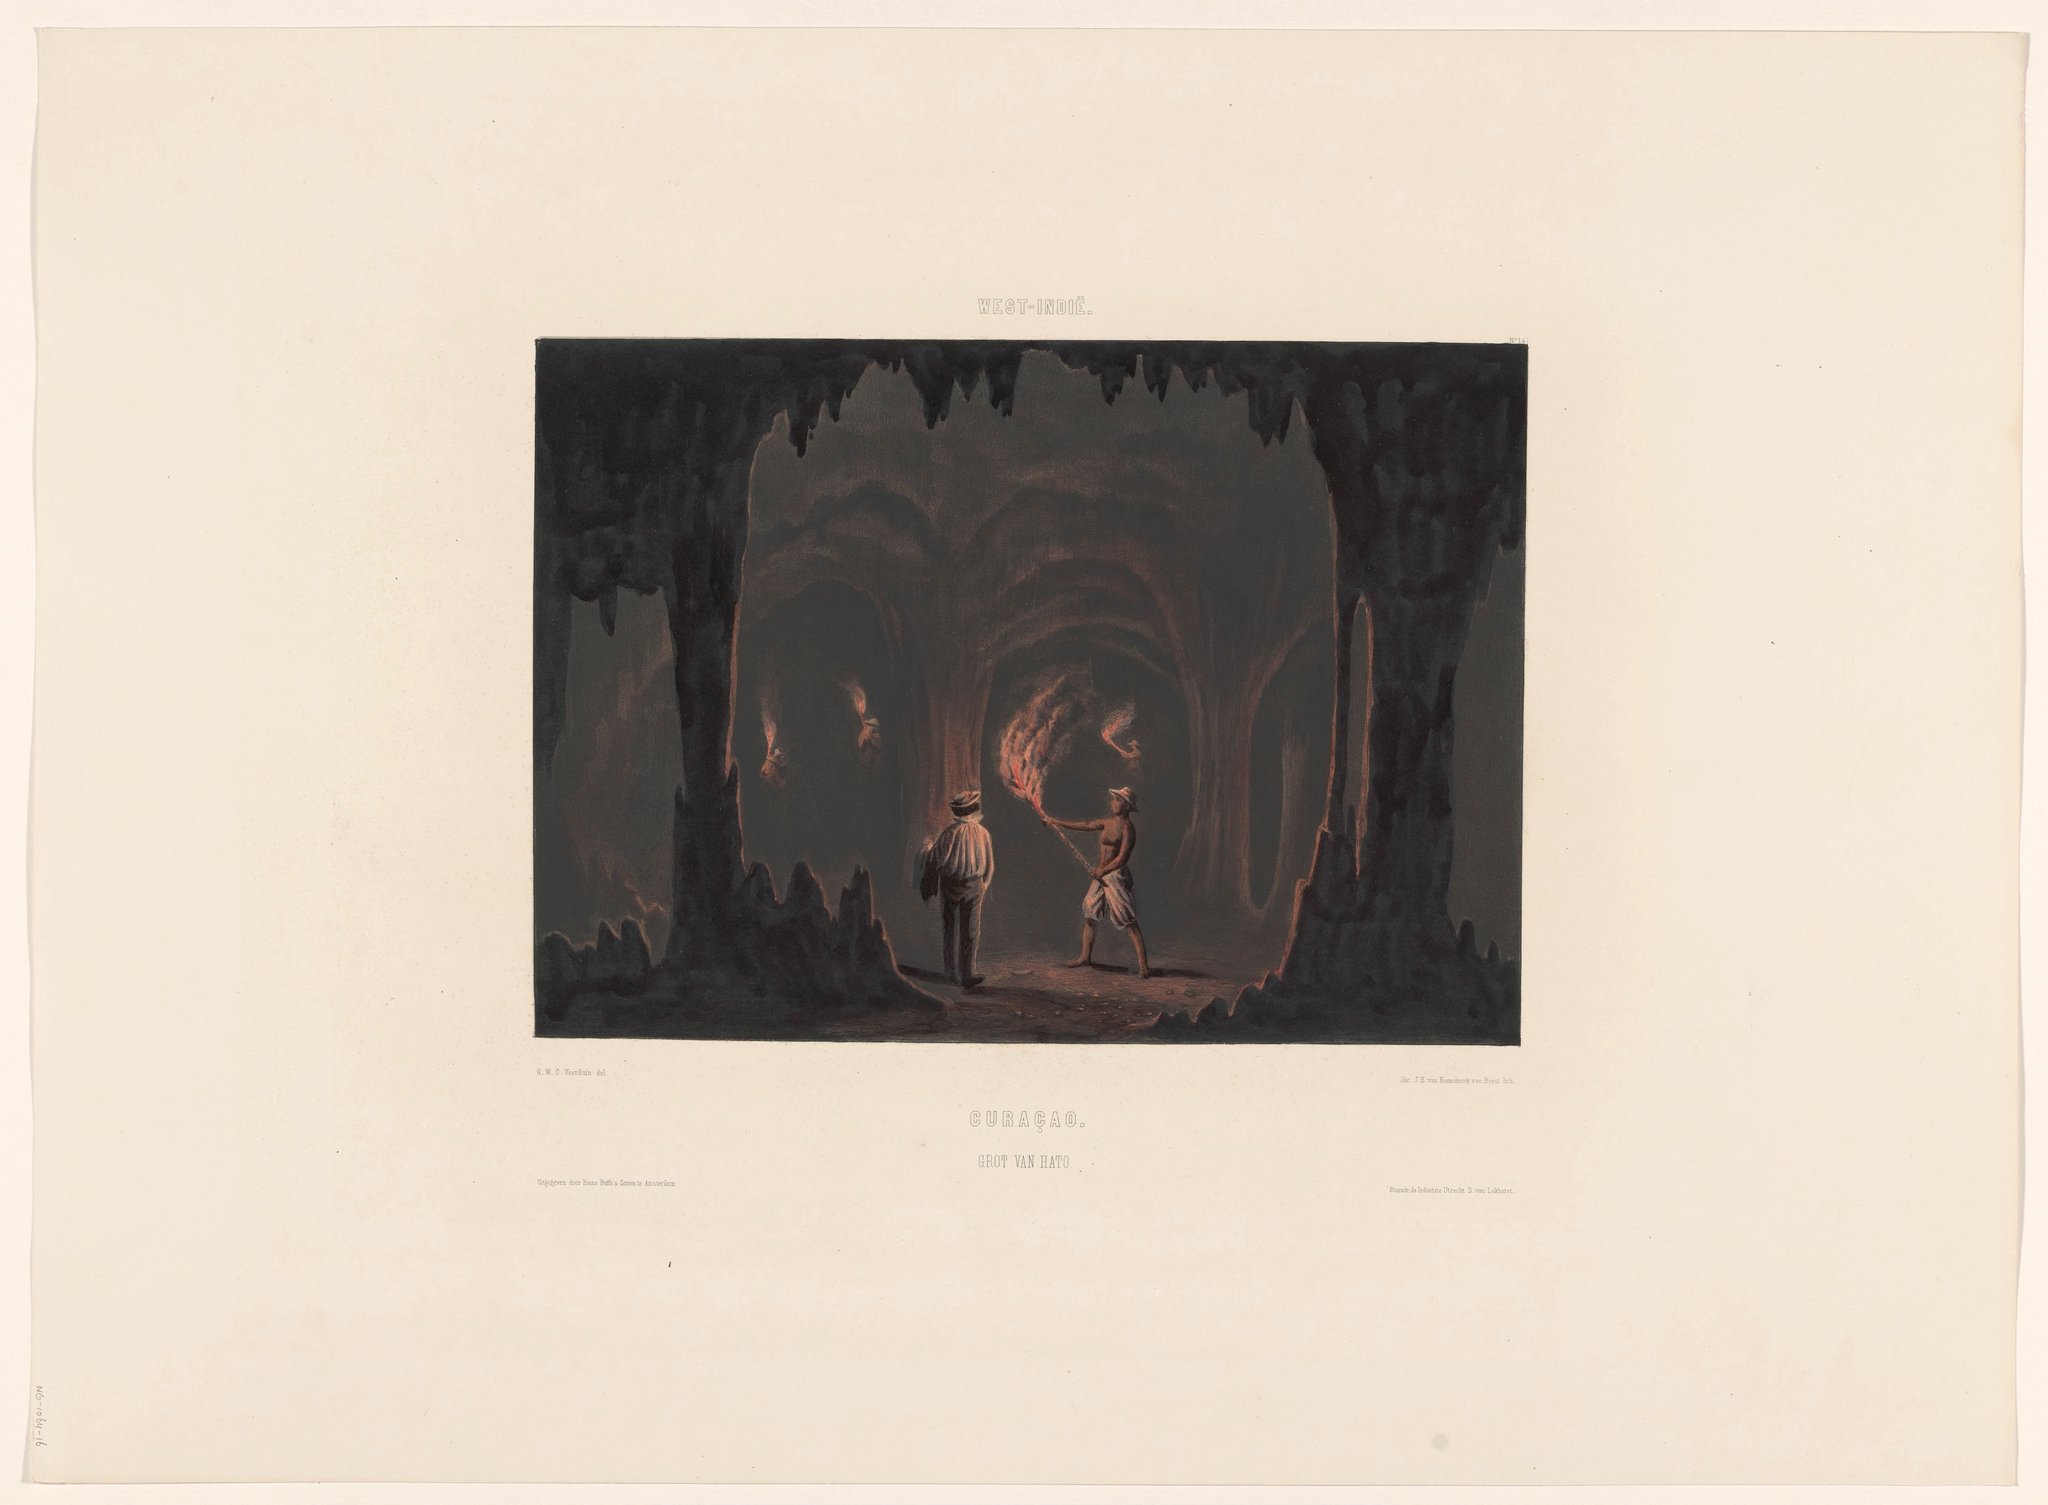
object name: print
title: Curaçao. Grot van Hato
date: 1860-1862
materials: paper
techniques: lithograph, hand coloring, lacquer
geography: netherlands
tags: colonial system, cave, grotto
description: Gezicht in de grotten van Hato op Curaçao. Gidsen met fakkels tonen een bezoeker de grotten. Onderdeel van het plaatwerk 'Gezigten uit Neerland's West-Indien'.